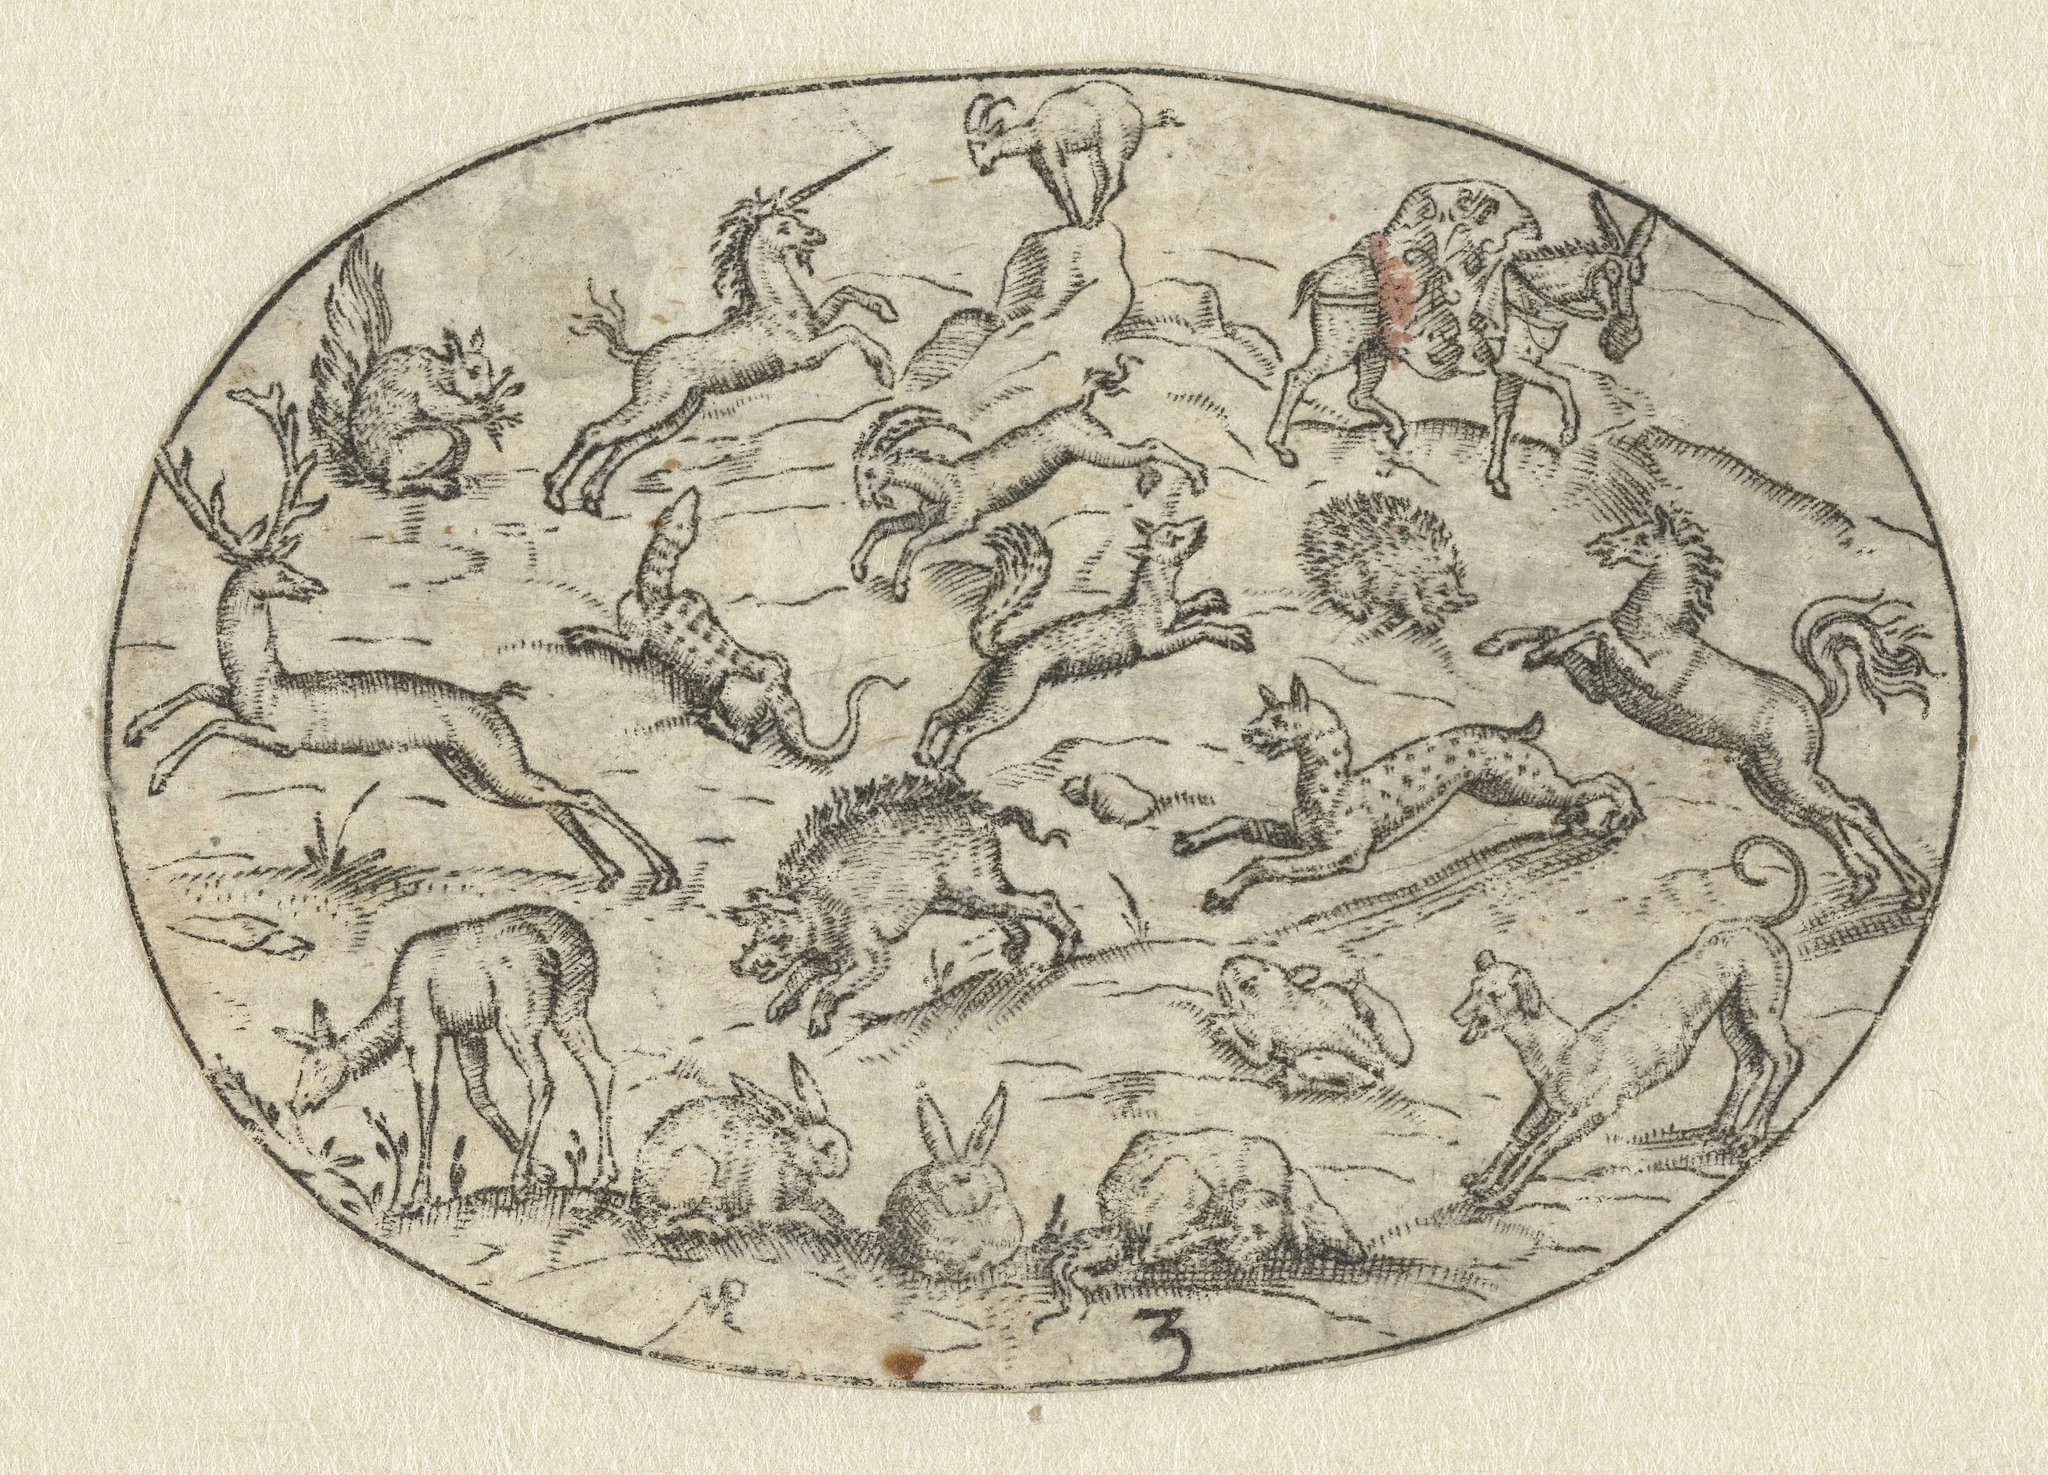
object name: ornament print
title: Ovaal met achttien dieren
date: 1594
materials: paper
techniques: engraving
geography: ansbach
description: Linksboven rent een eenhoorn, onderaan zitten twee konijnen. Blad 3 uit serie van titelblad en 7 genummerde bladen.